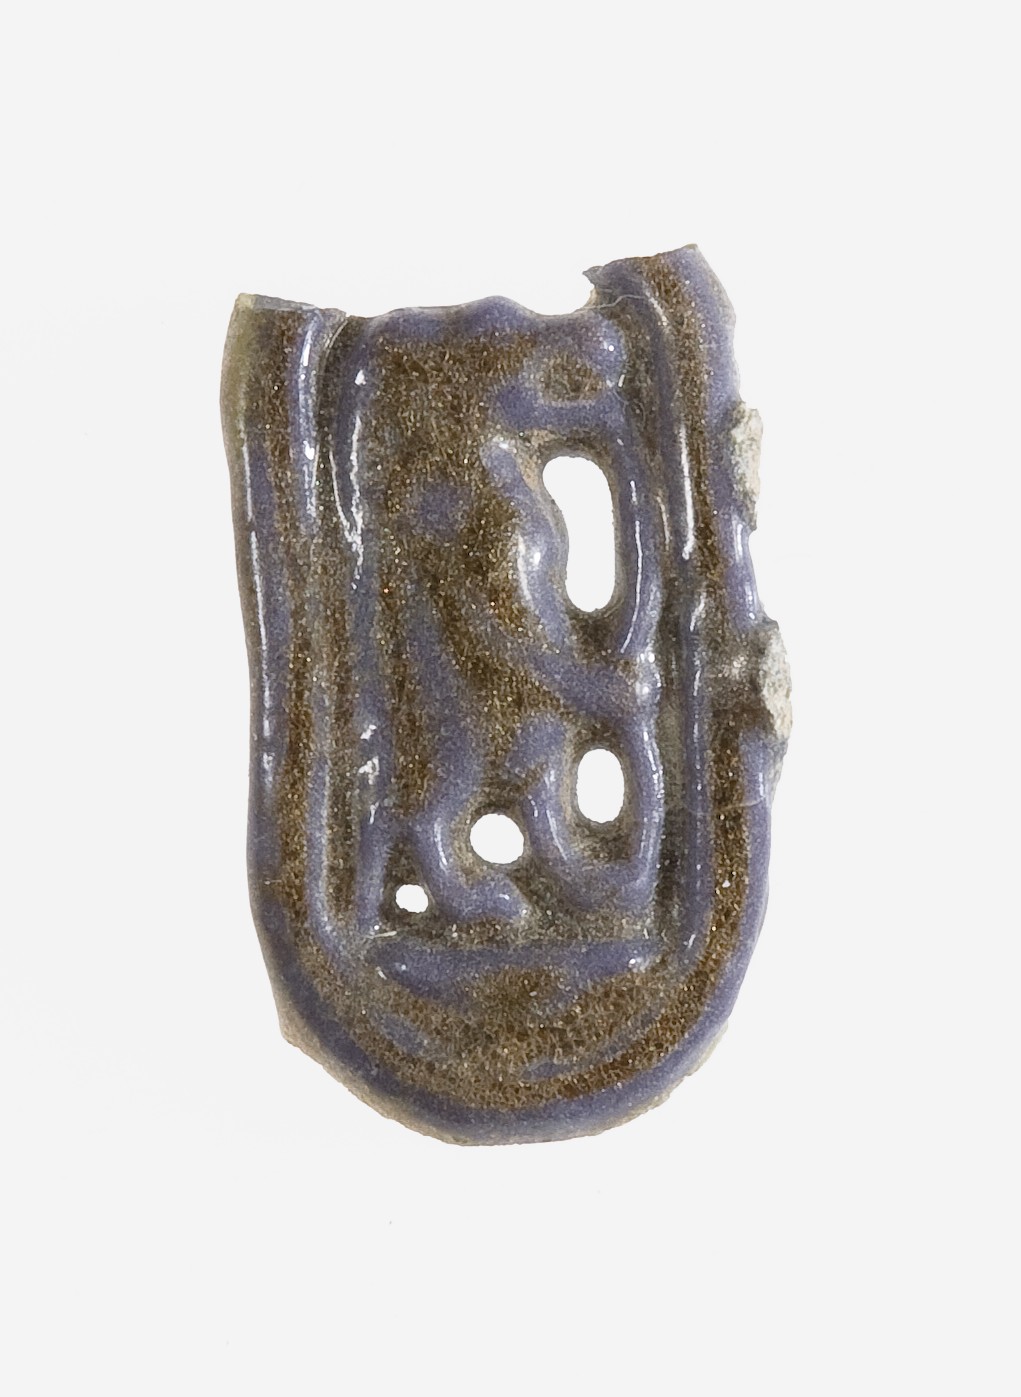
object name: ring fragment, taweret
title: Ring Fragment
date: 1390-1352 BCE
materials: faience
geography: egypt